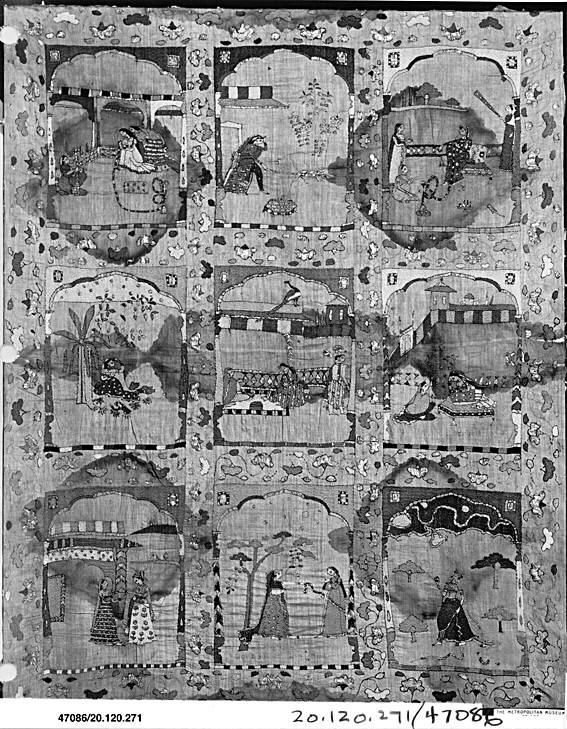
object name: cover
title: Cover (Rumal)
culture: indian, himachal pradesh, chamba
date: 1701-1800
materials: cotton, silk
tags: birds,men,women,trees